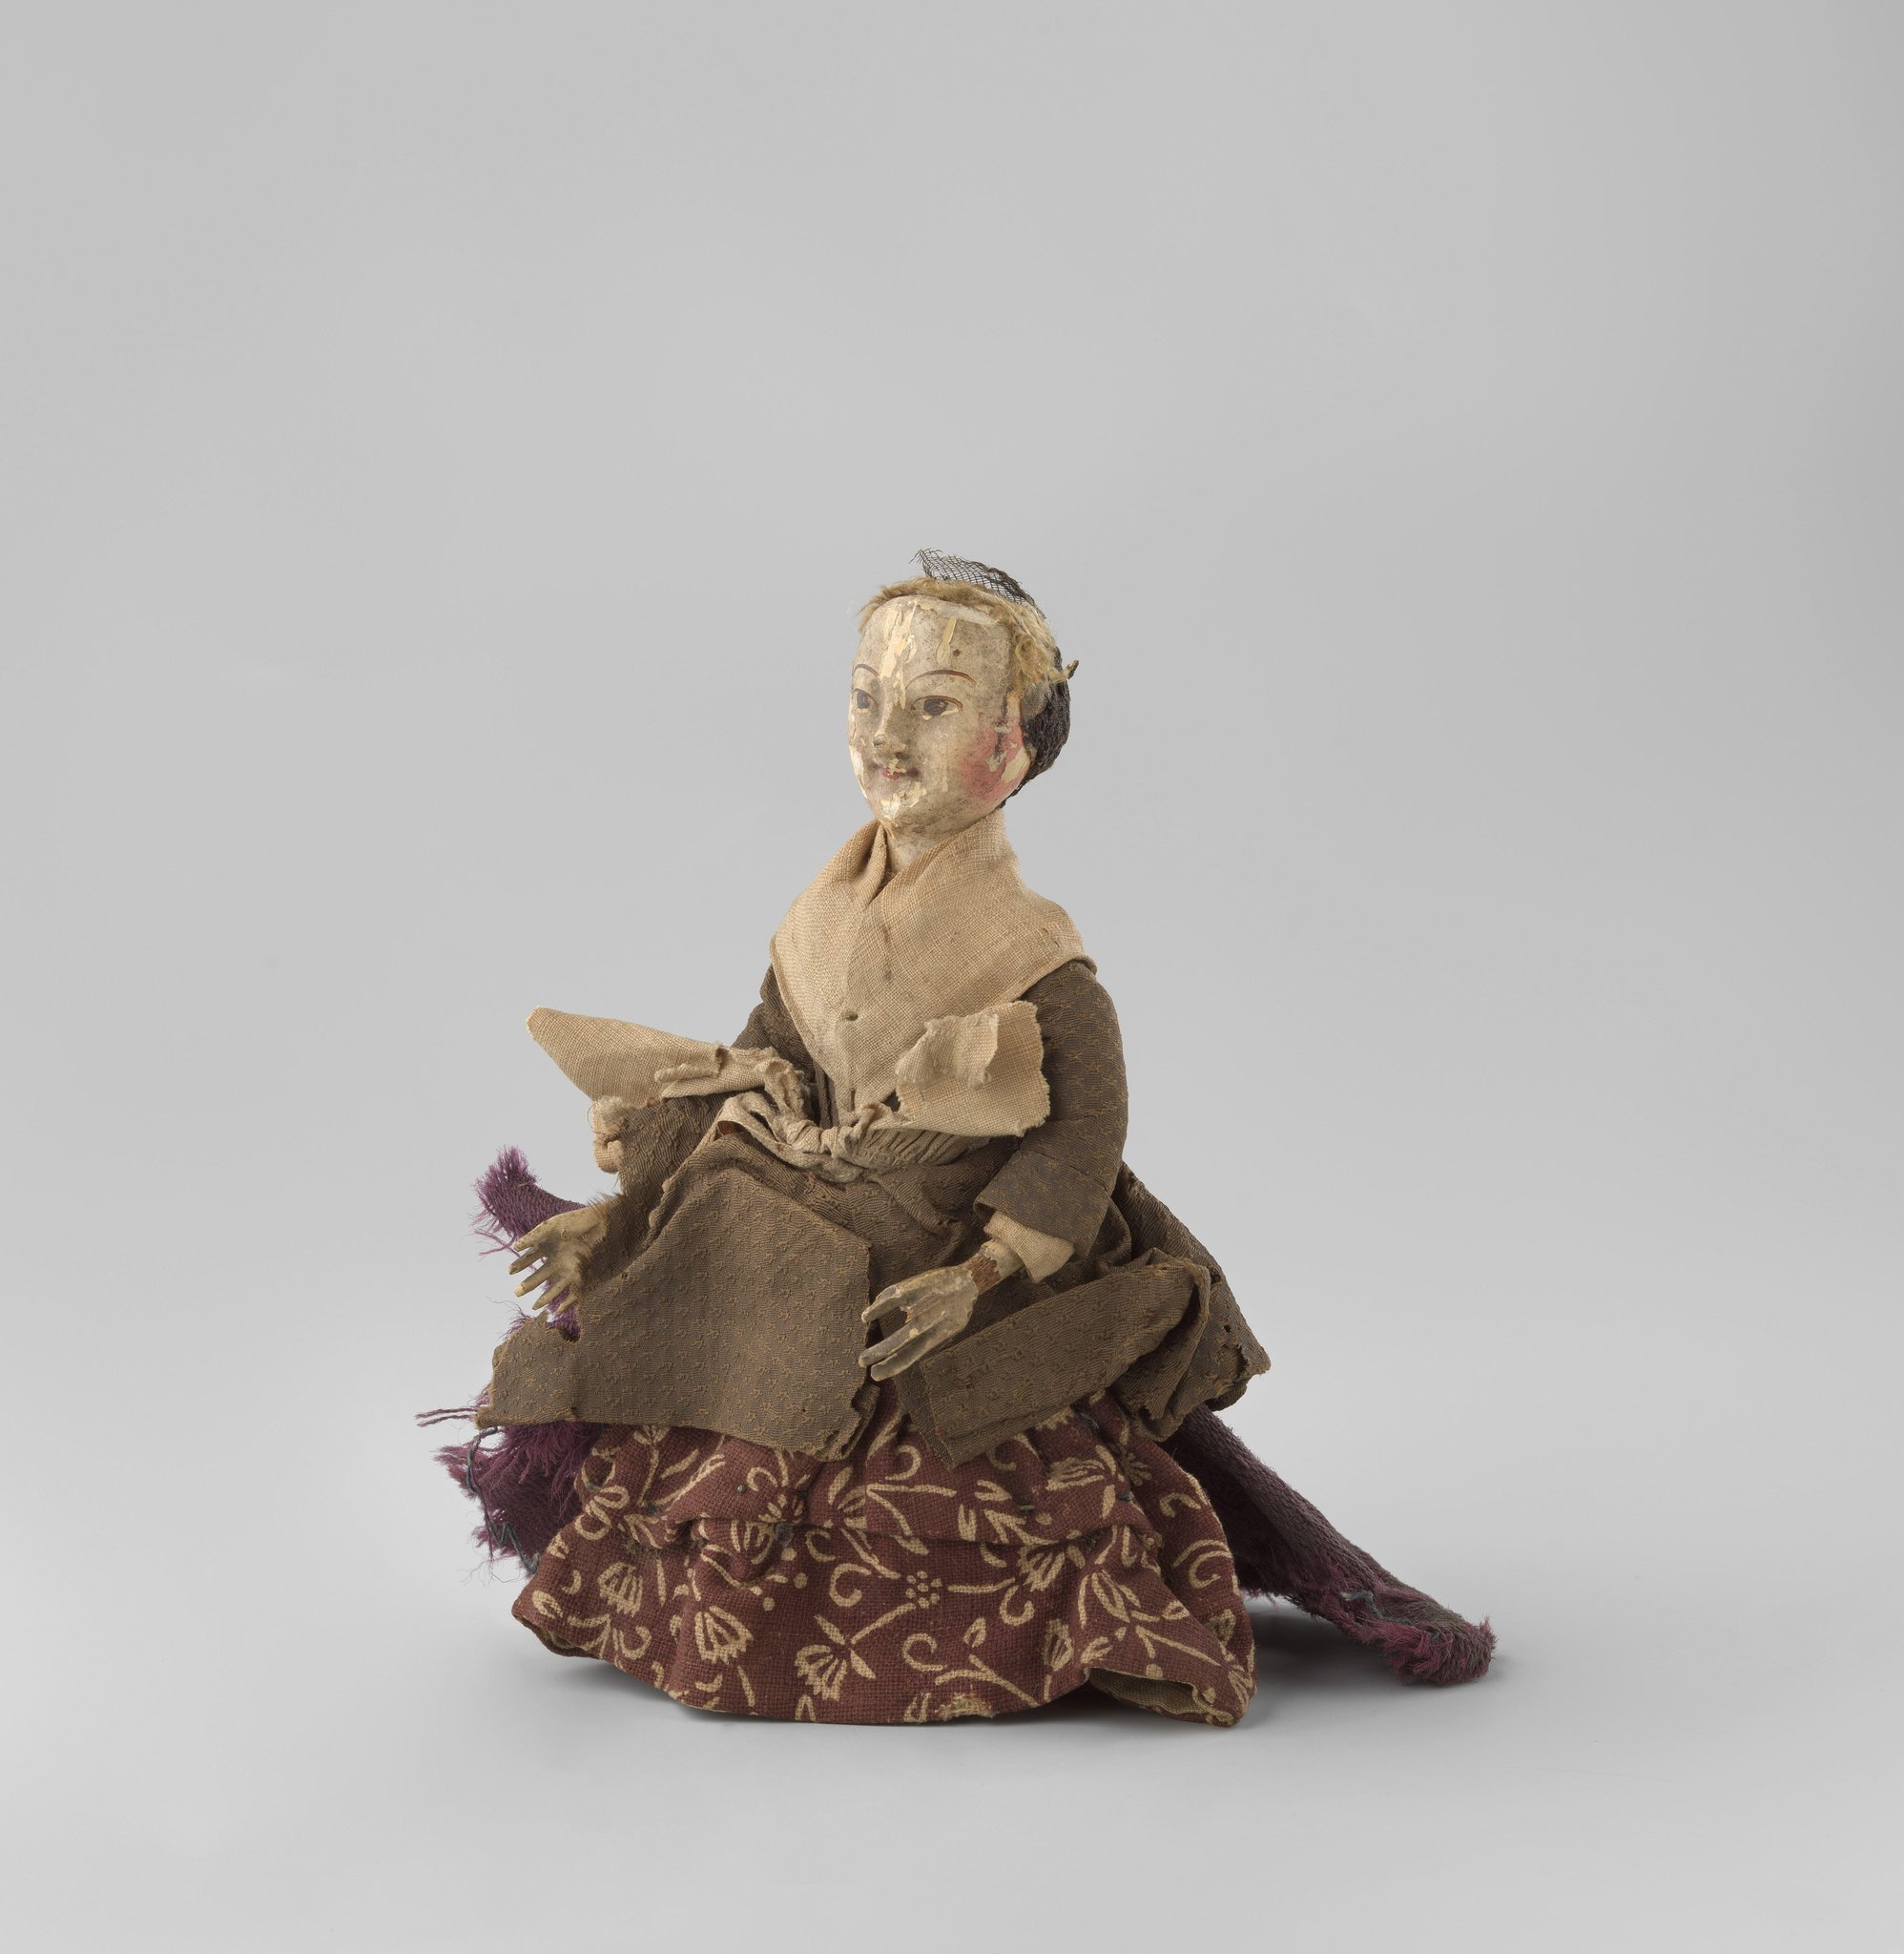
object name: doll's clothing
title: Pop met kop en handen van hout, met kleding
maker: Anonymous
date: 1700-1800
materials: textile, wood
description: Pop met kop en handen van hout. Kleding: zwarte rok en schort en driekante doek. Grondknoopsel van de pruik aanwezig. Opmerking: van het schort alleen nog het gerimpelde bovenstuk over.